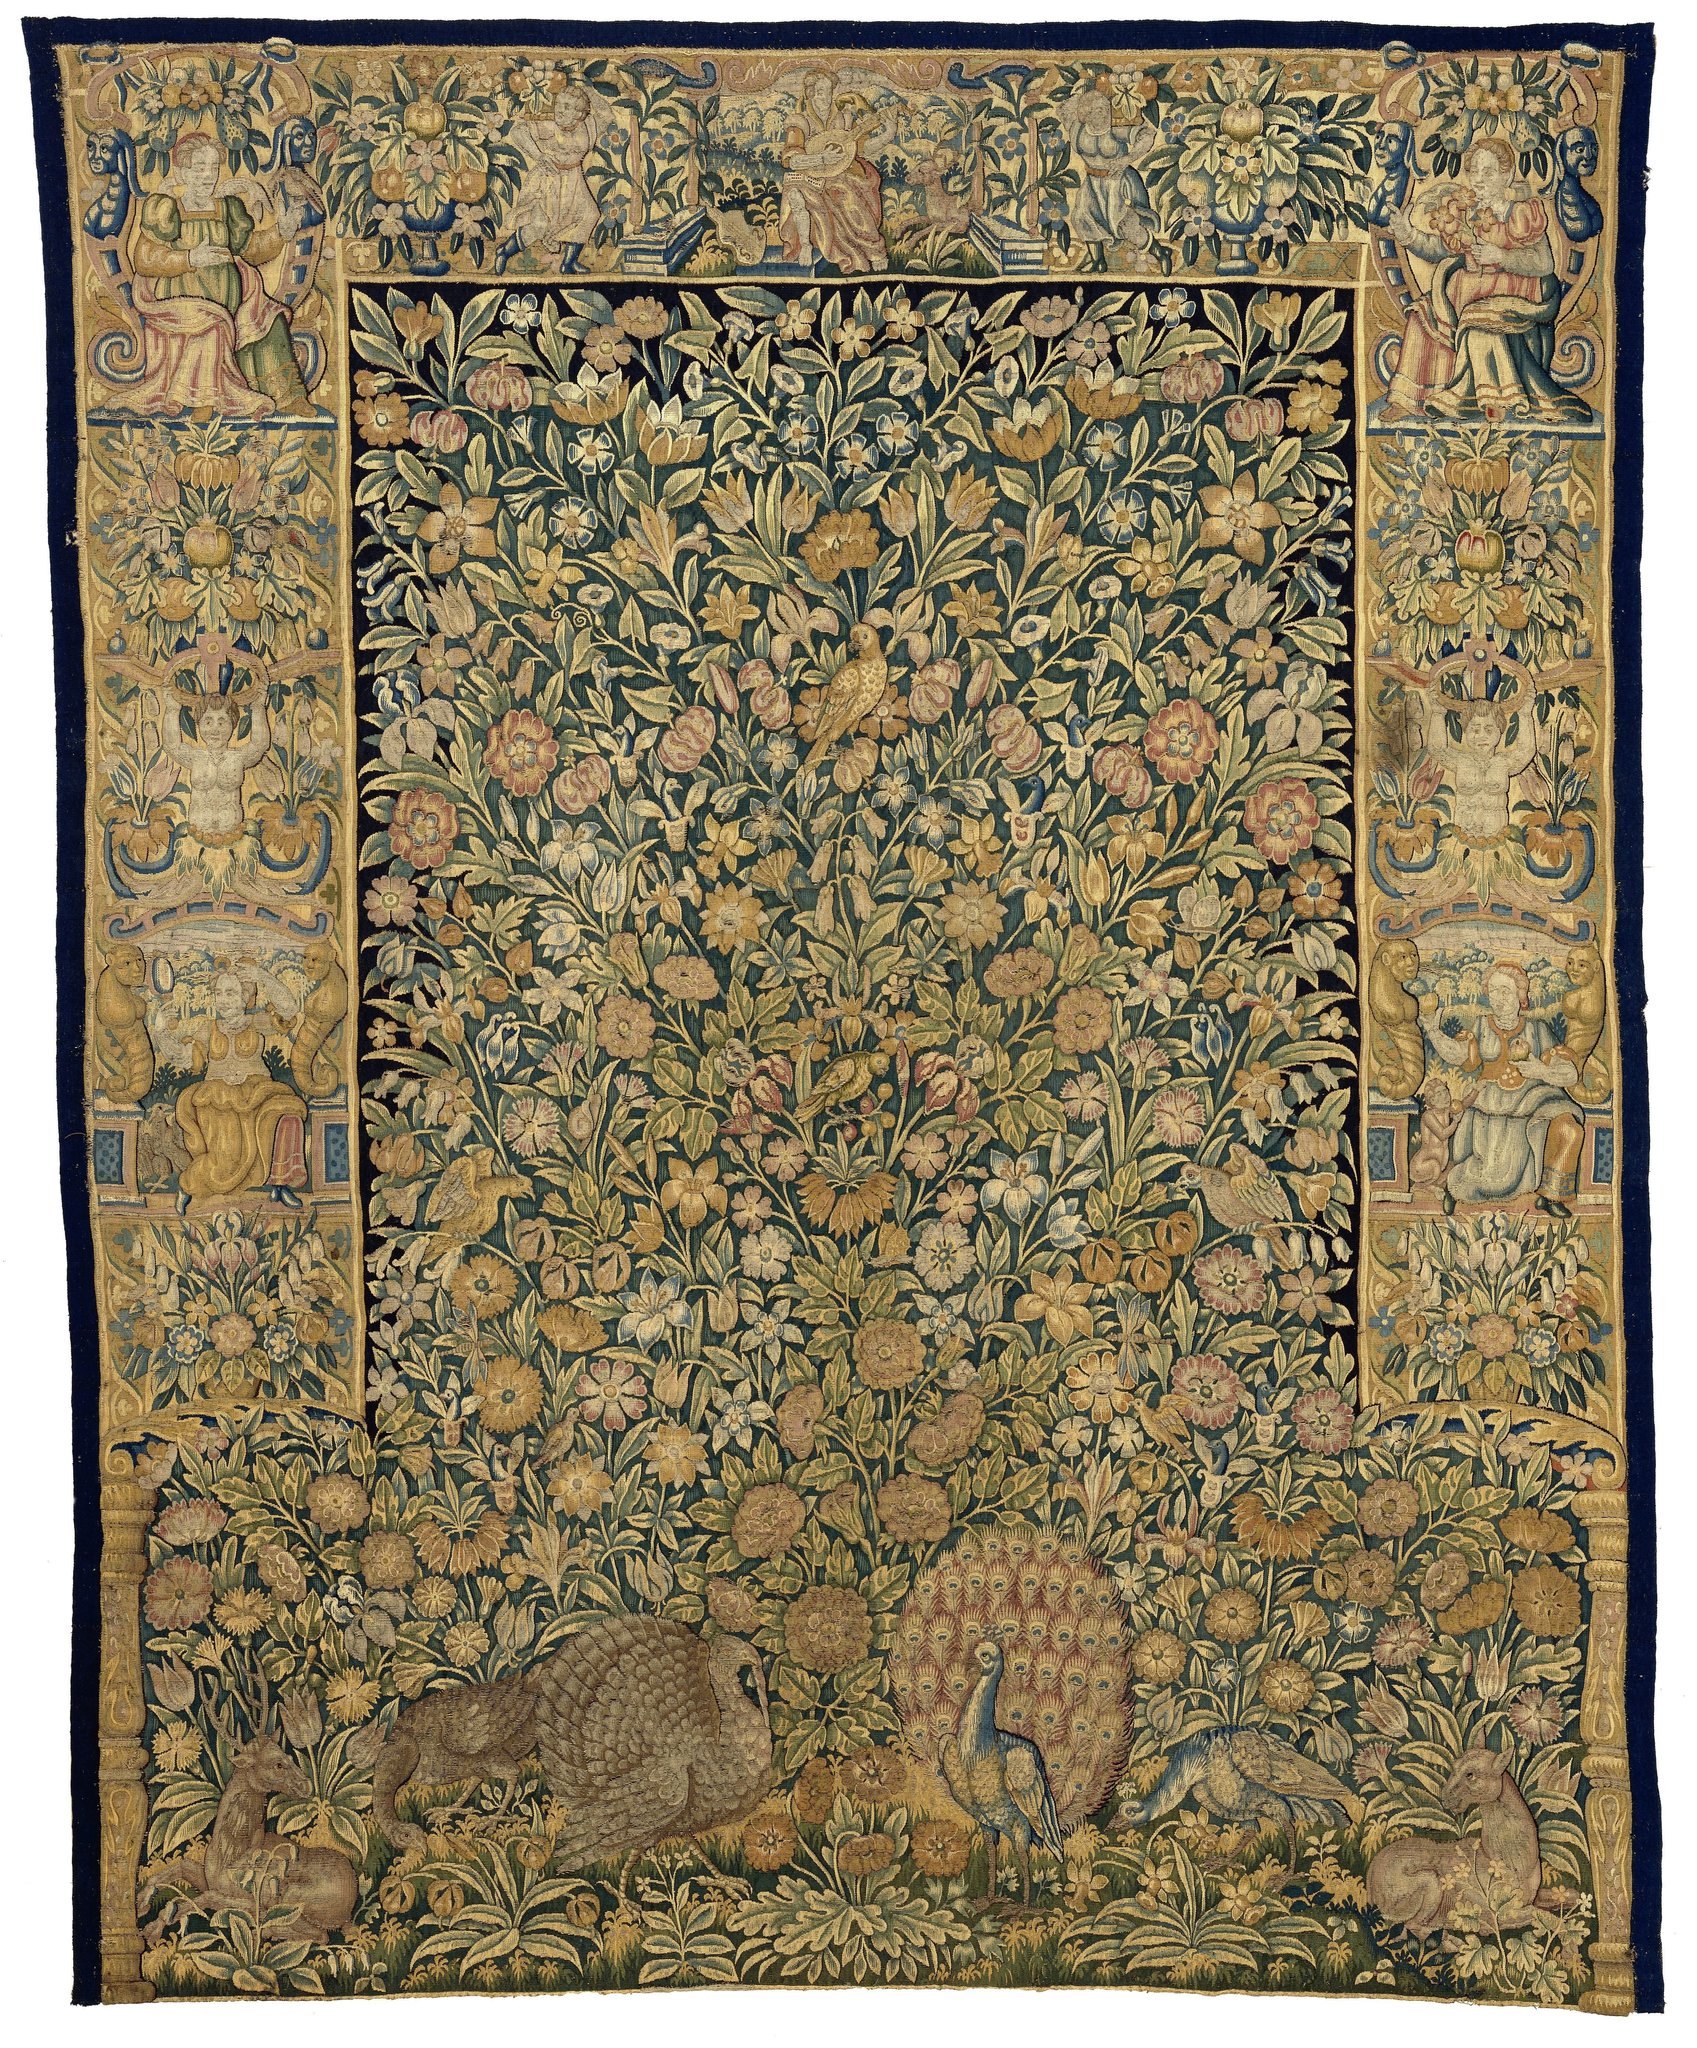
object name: tapestry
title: Verdure met pauwen, kalkoenen en herten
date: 1600-1630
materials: silk, wool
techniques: tapestry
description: Wandtapijt, kleinbladige verdure met dieren en een rand met vrouwenfiguren die de vijf zintuigen symboliseren.